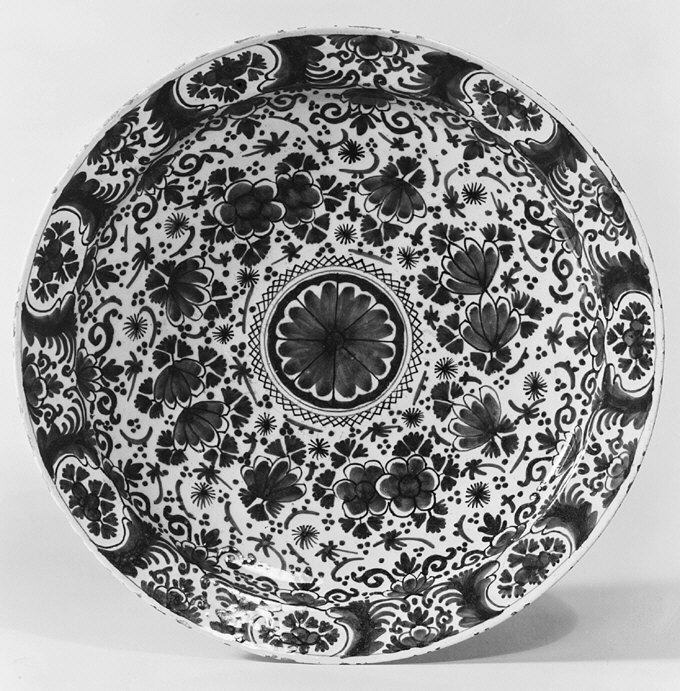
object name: dish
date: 1701-1733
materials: earthenware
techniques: glazing